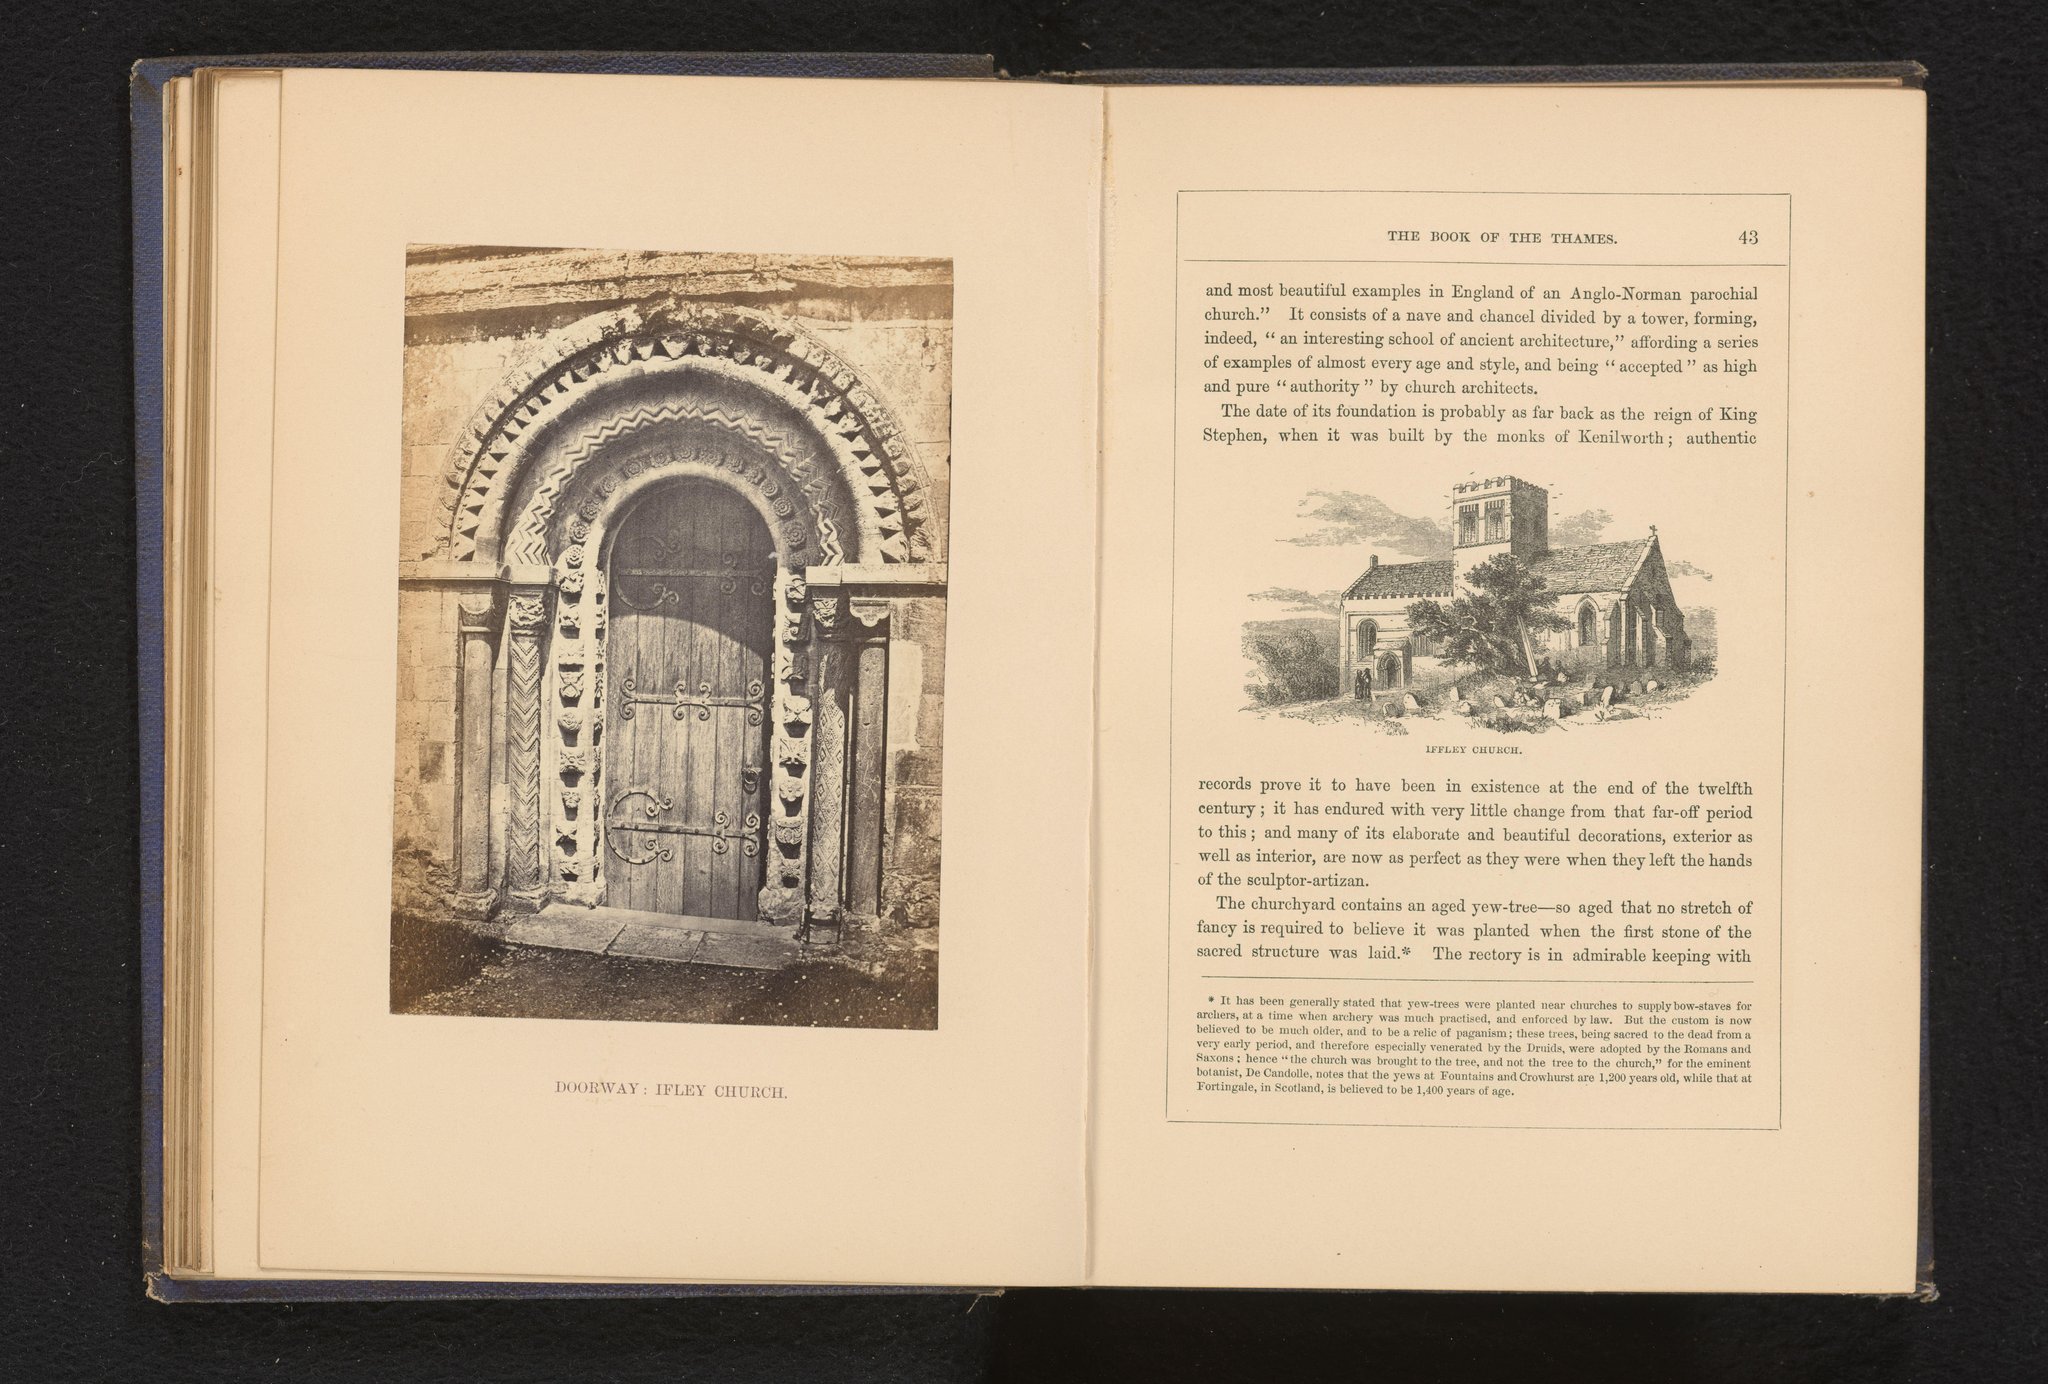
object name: photograph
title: Doorway: Ifley Church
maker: francis frith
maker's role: publisher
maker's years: 1822-1898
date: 1862-1867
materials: paper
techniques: albumen print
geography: iffley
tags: parts of church exterior and annexes: portal, thames